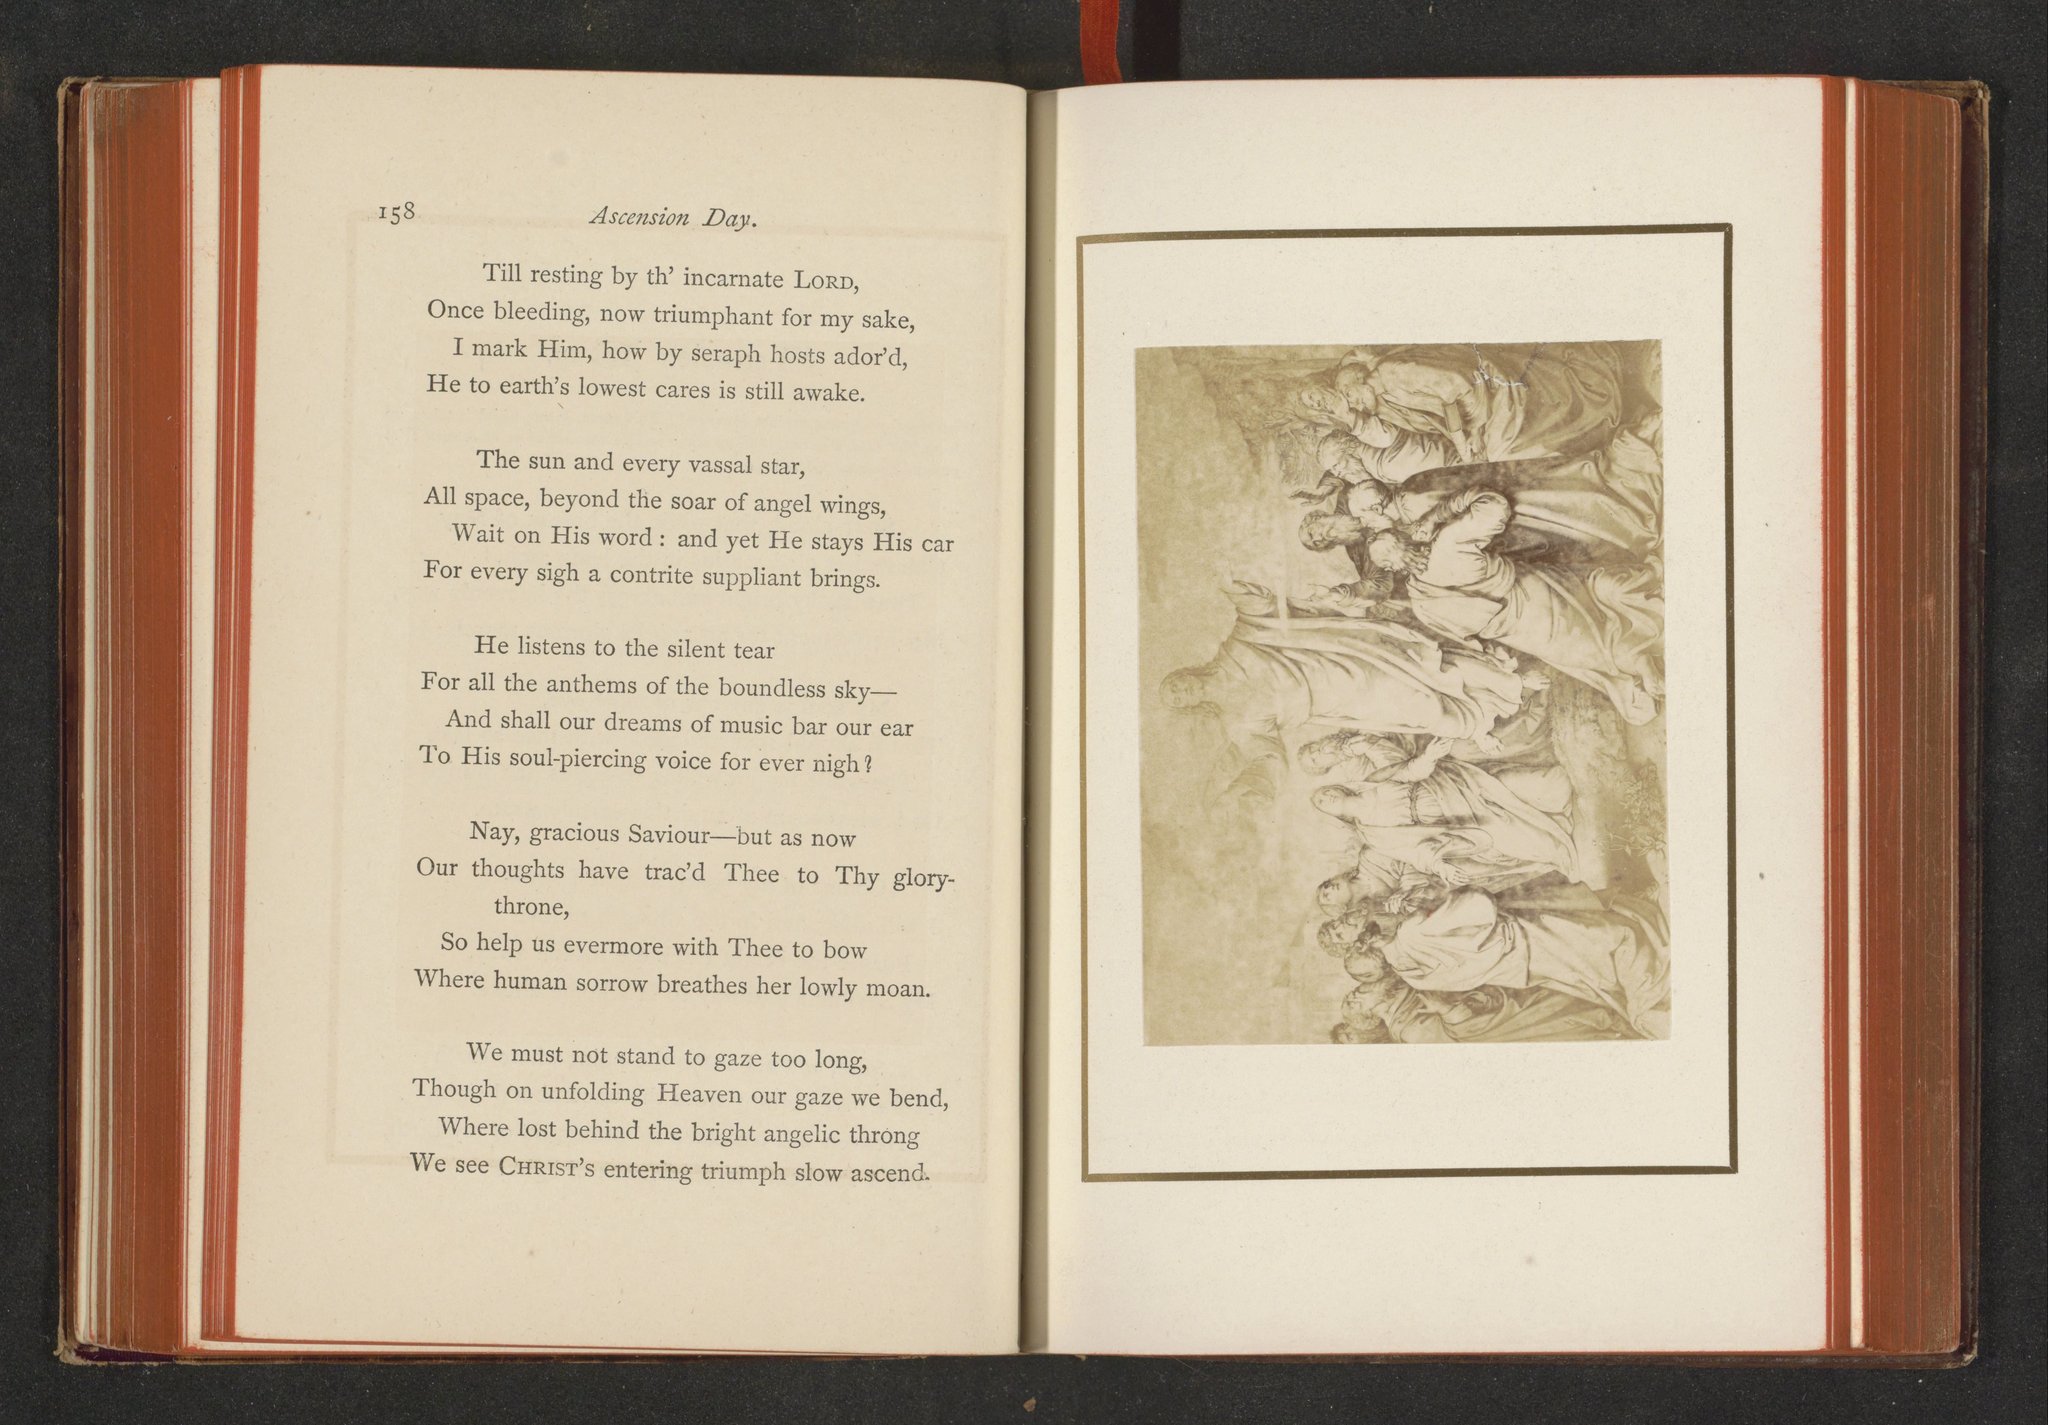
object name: page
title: Fotoreproductie van een prent, voorstellende de hemelvaart van Christus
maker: Anonymous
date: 1870-1875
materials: photographic support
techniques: albumen print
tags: the ascension (christ surrounded by radiant light or in a mandorla)